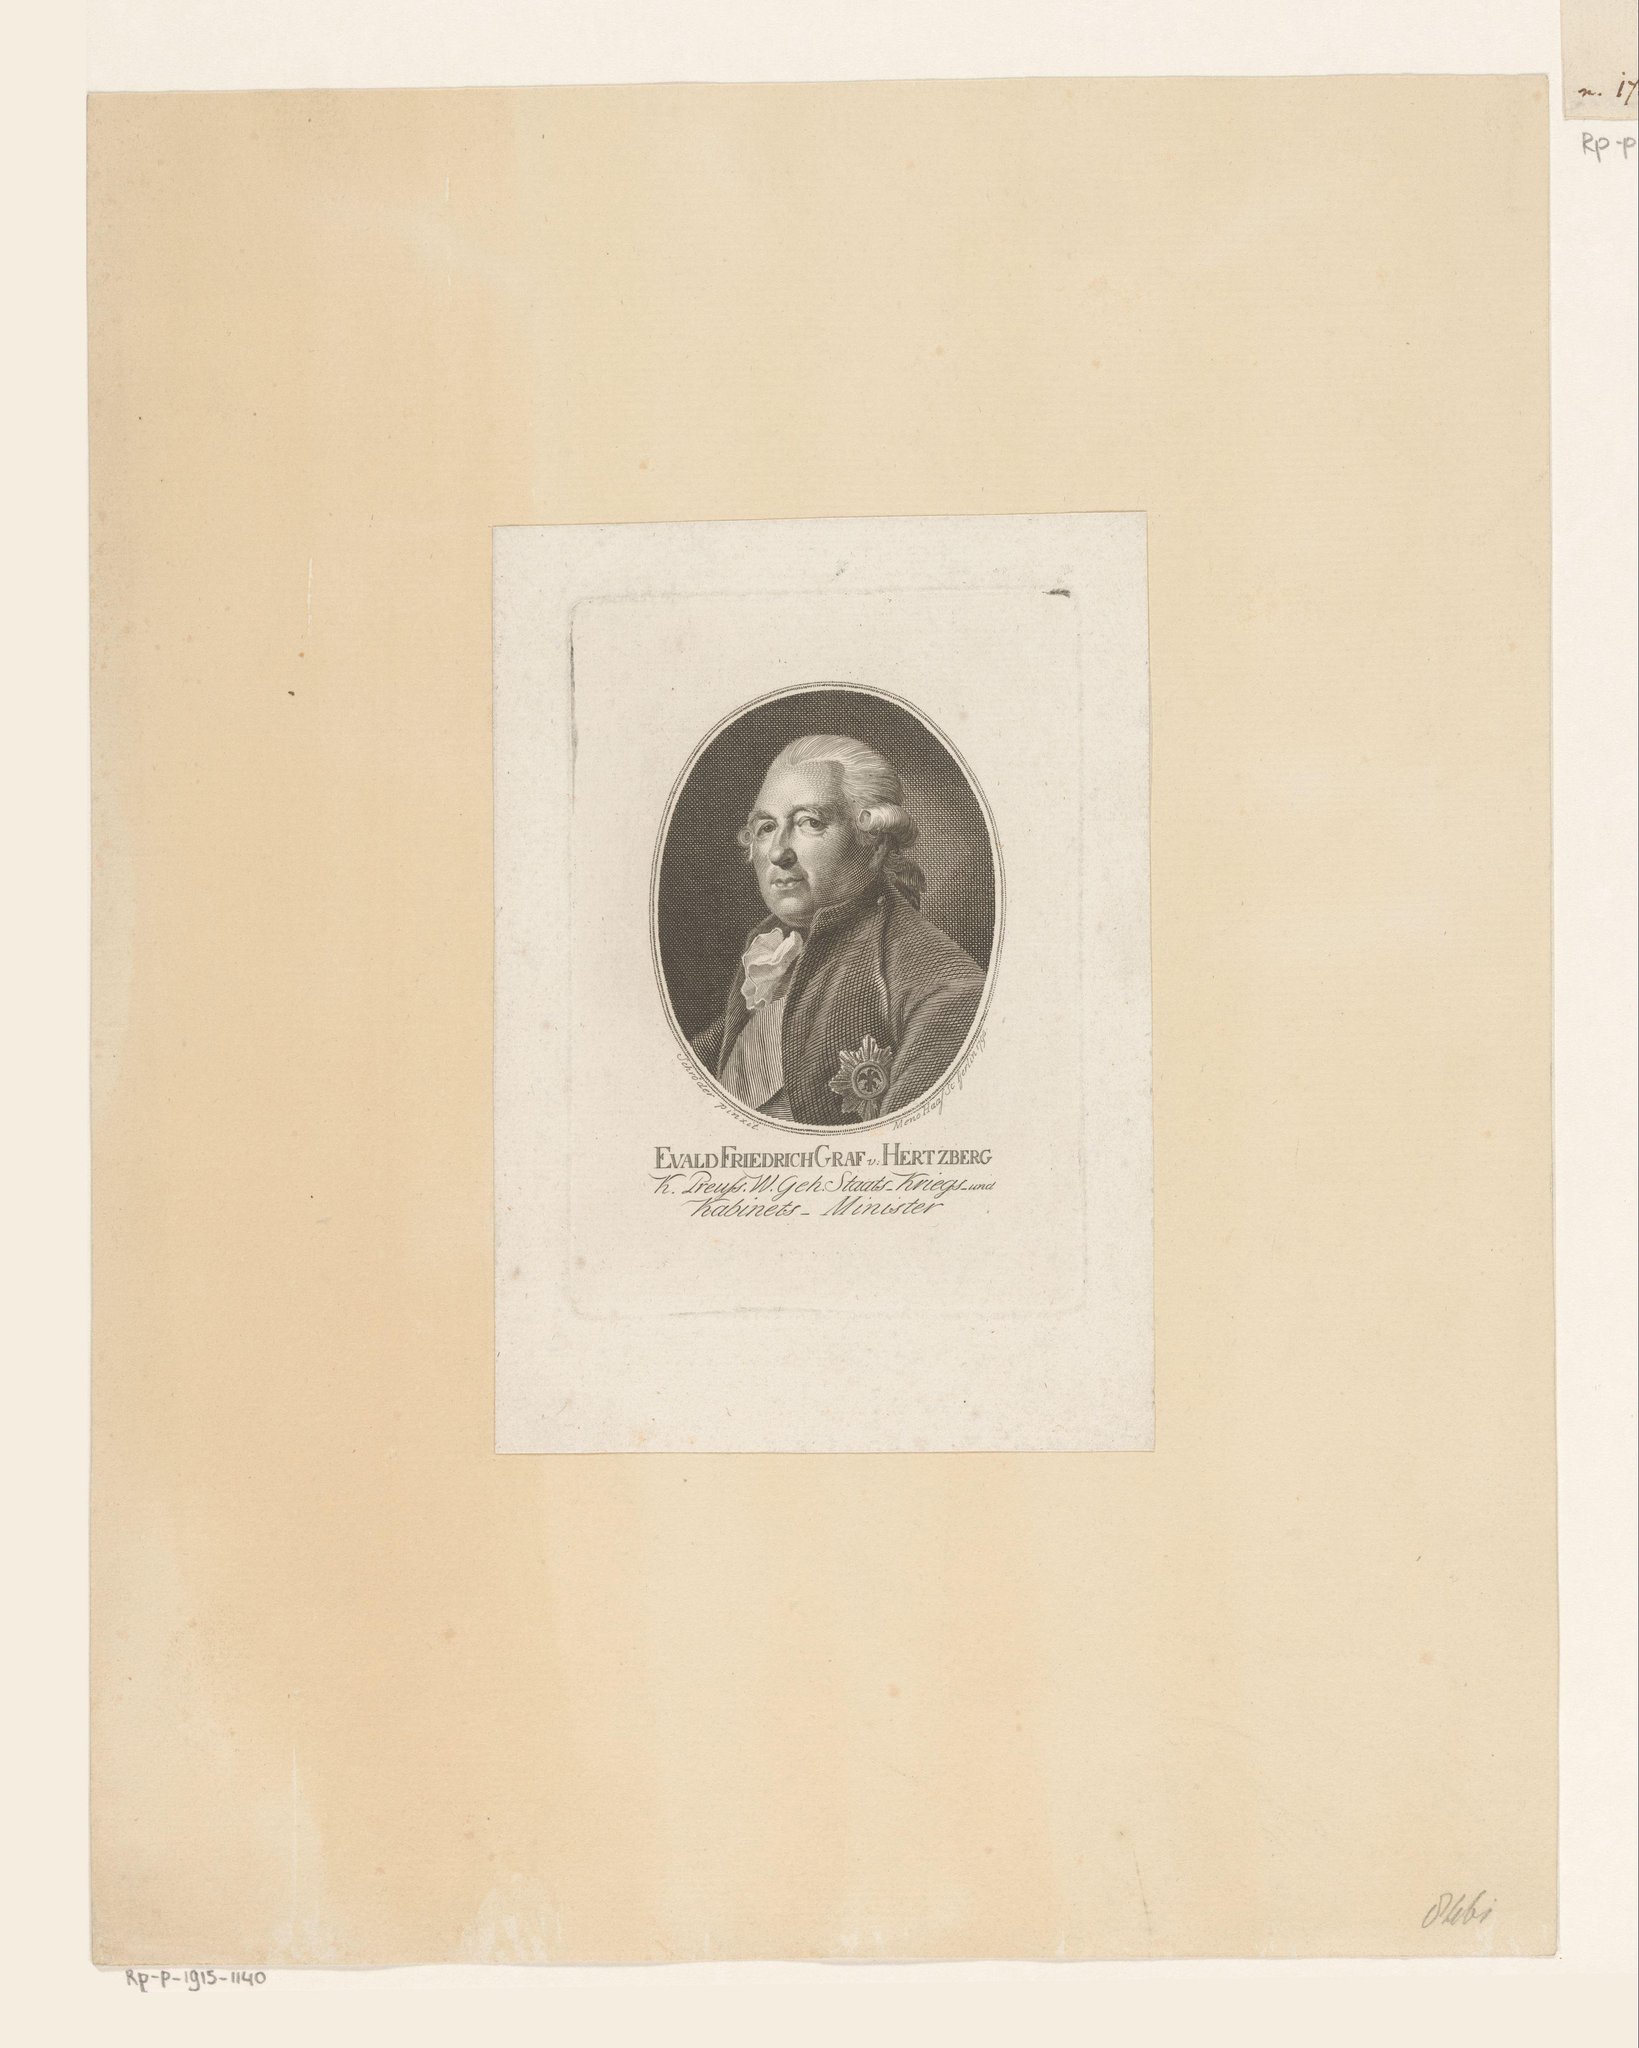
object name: print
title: Portret van Ewald Friedrich von Hertzberg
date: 1794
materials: paper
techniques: engraving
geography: berlin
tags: poland, berlin, ewald friedrich von hertzberg (graaf), knighthood order (with name) - insignia of a knighthood order, e.g.: badge, chain (with name of order), historical persons, politician, e.g. party leader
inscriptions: date